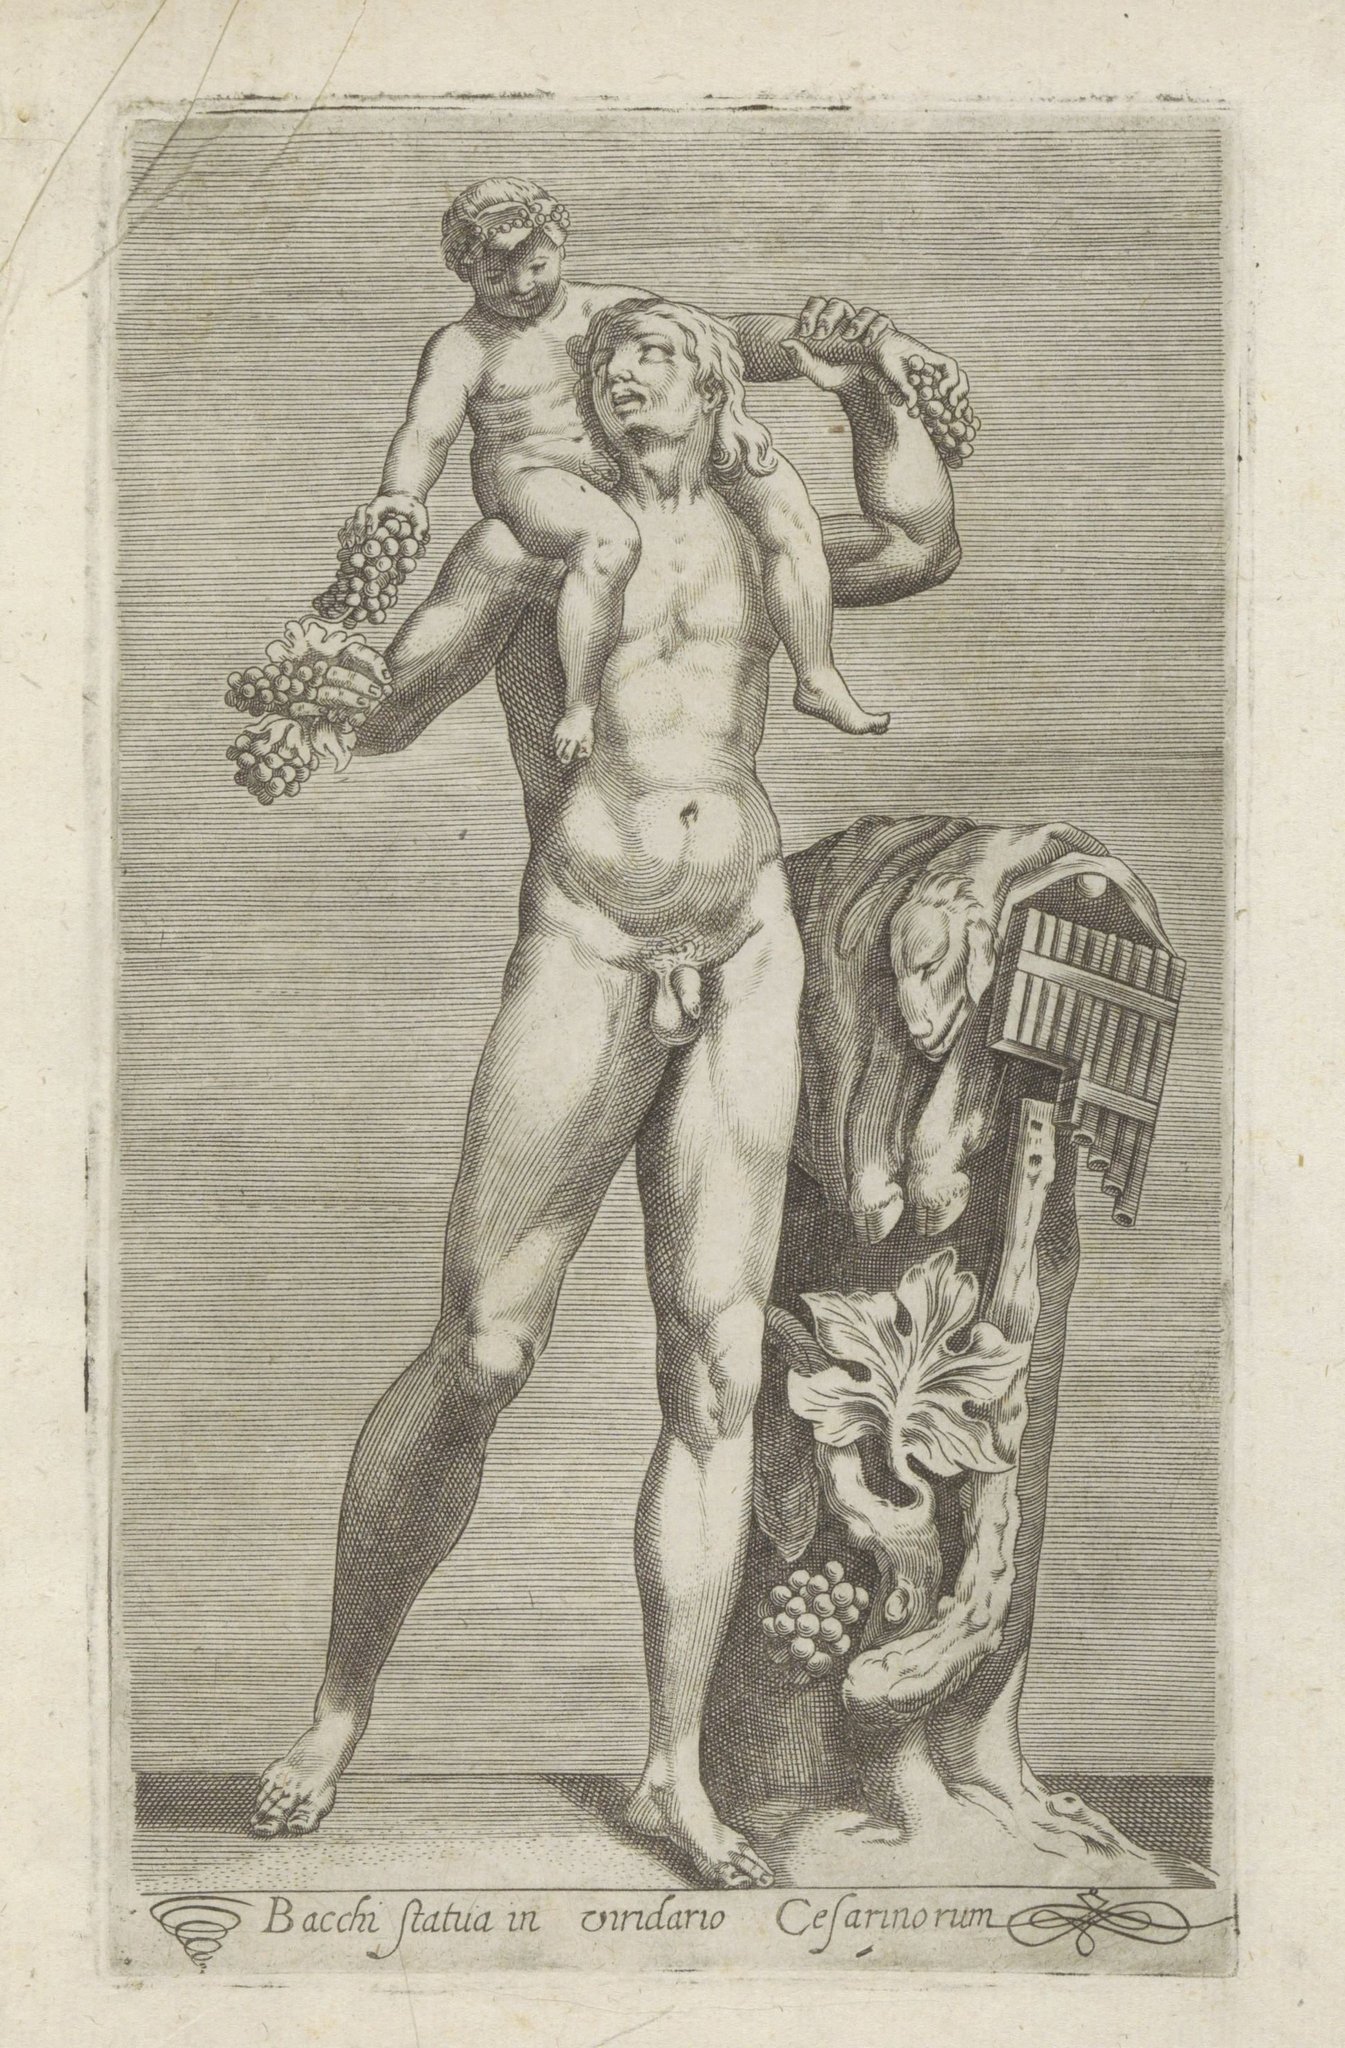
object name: album leaf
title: Bacchi statua in viridario Cesarinorum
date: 1584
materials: paper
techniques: engraving, intaglio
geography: italy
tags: bacchus brought up by satyrs, maenads and silenus, piece of sculpture, reproduction of a piece of sculpture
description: Deze prent maakt deel uit van een set van 79 prenten (+ titelprent) met voorstellingen van antieke sculpturen in Rome.